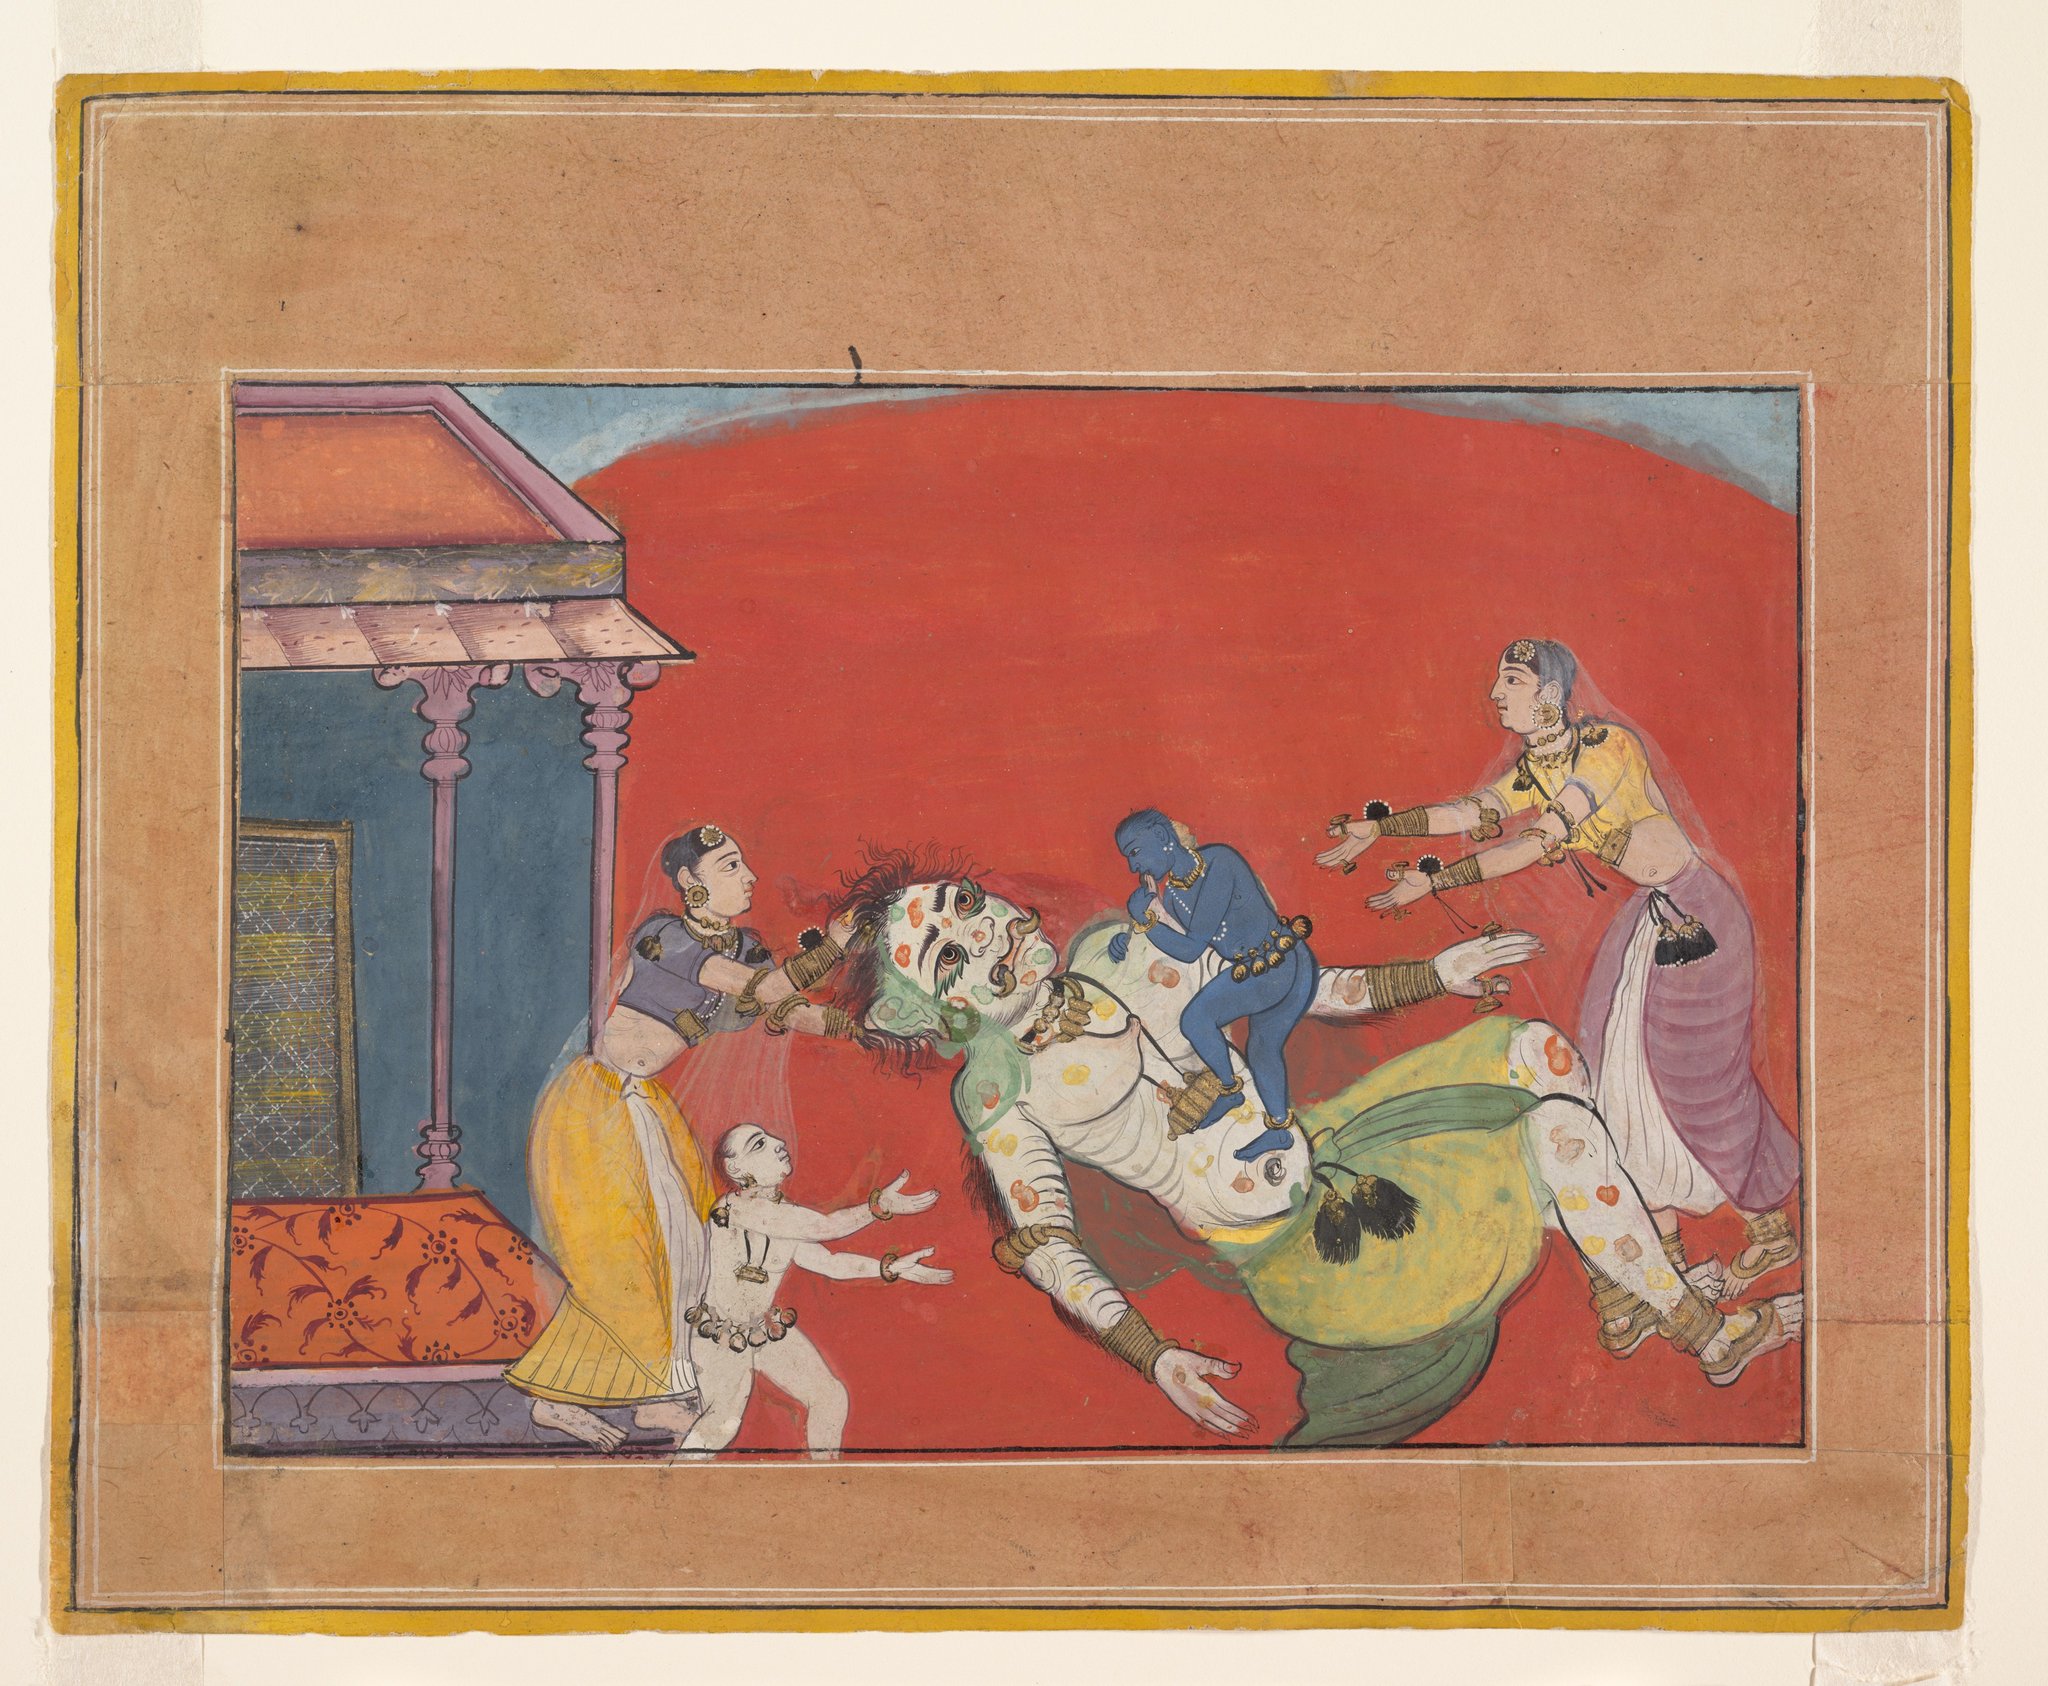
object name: folio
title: The Death of the Demoness Putana: Folio from a Bhagavata Purana Series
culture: western indian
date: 1610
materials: ink, paper, watercolor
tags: boys,women,demons,krishna,hinduism